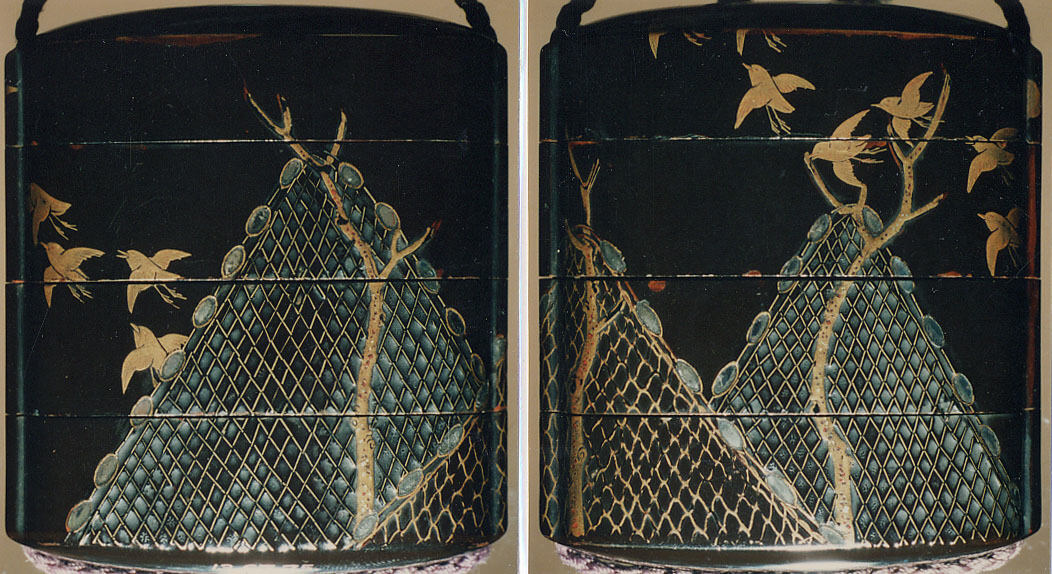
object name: inrō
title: Case (Inrō) with Design of Fishing Nets and Chidori in Flight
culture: japanese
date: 1701-1800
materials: gold, lacquer, metal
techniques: fundame, hiramakie, inlay, roiro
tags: birds